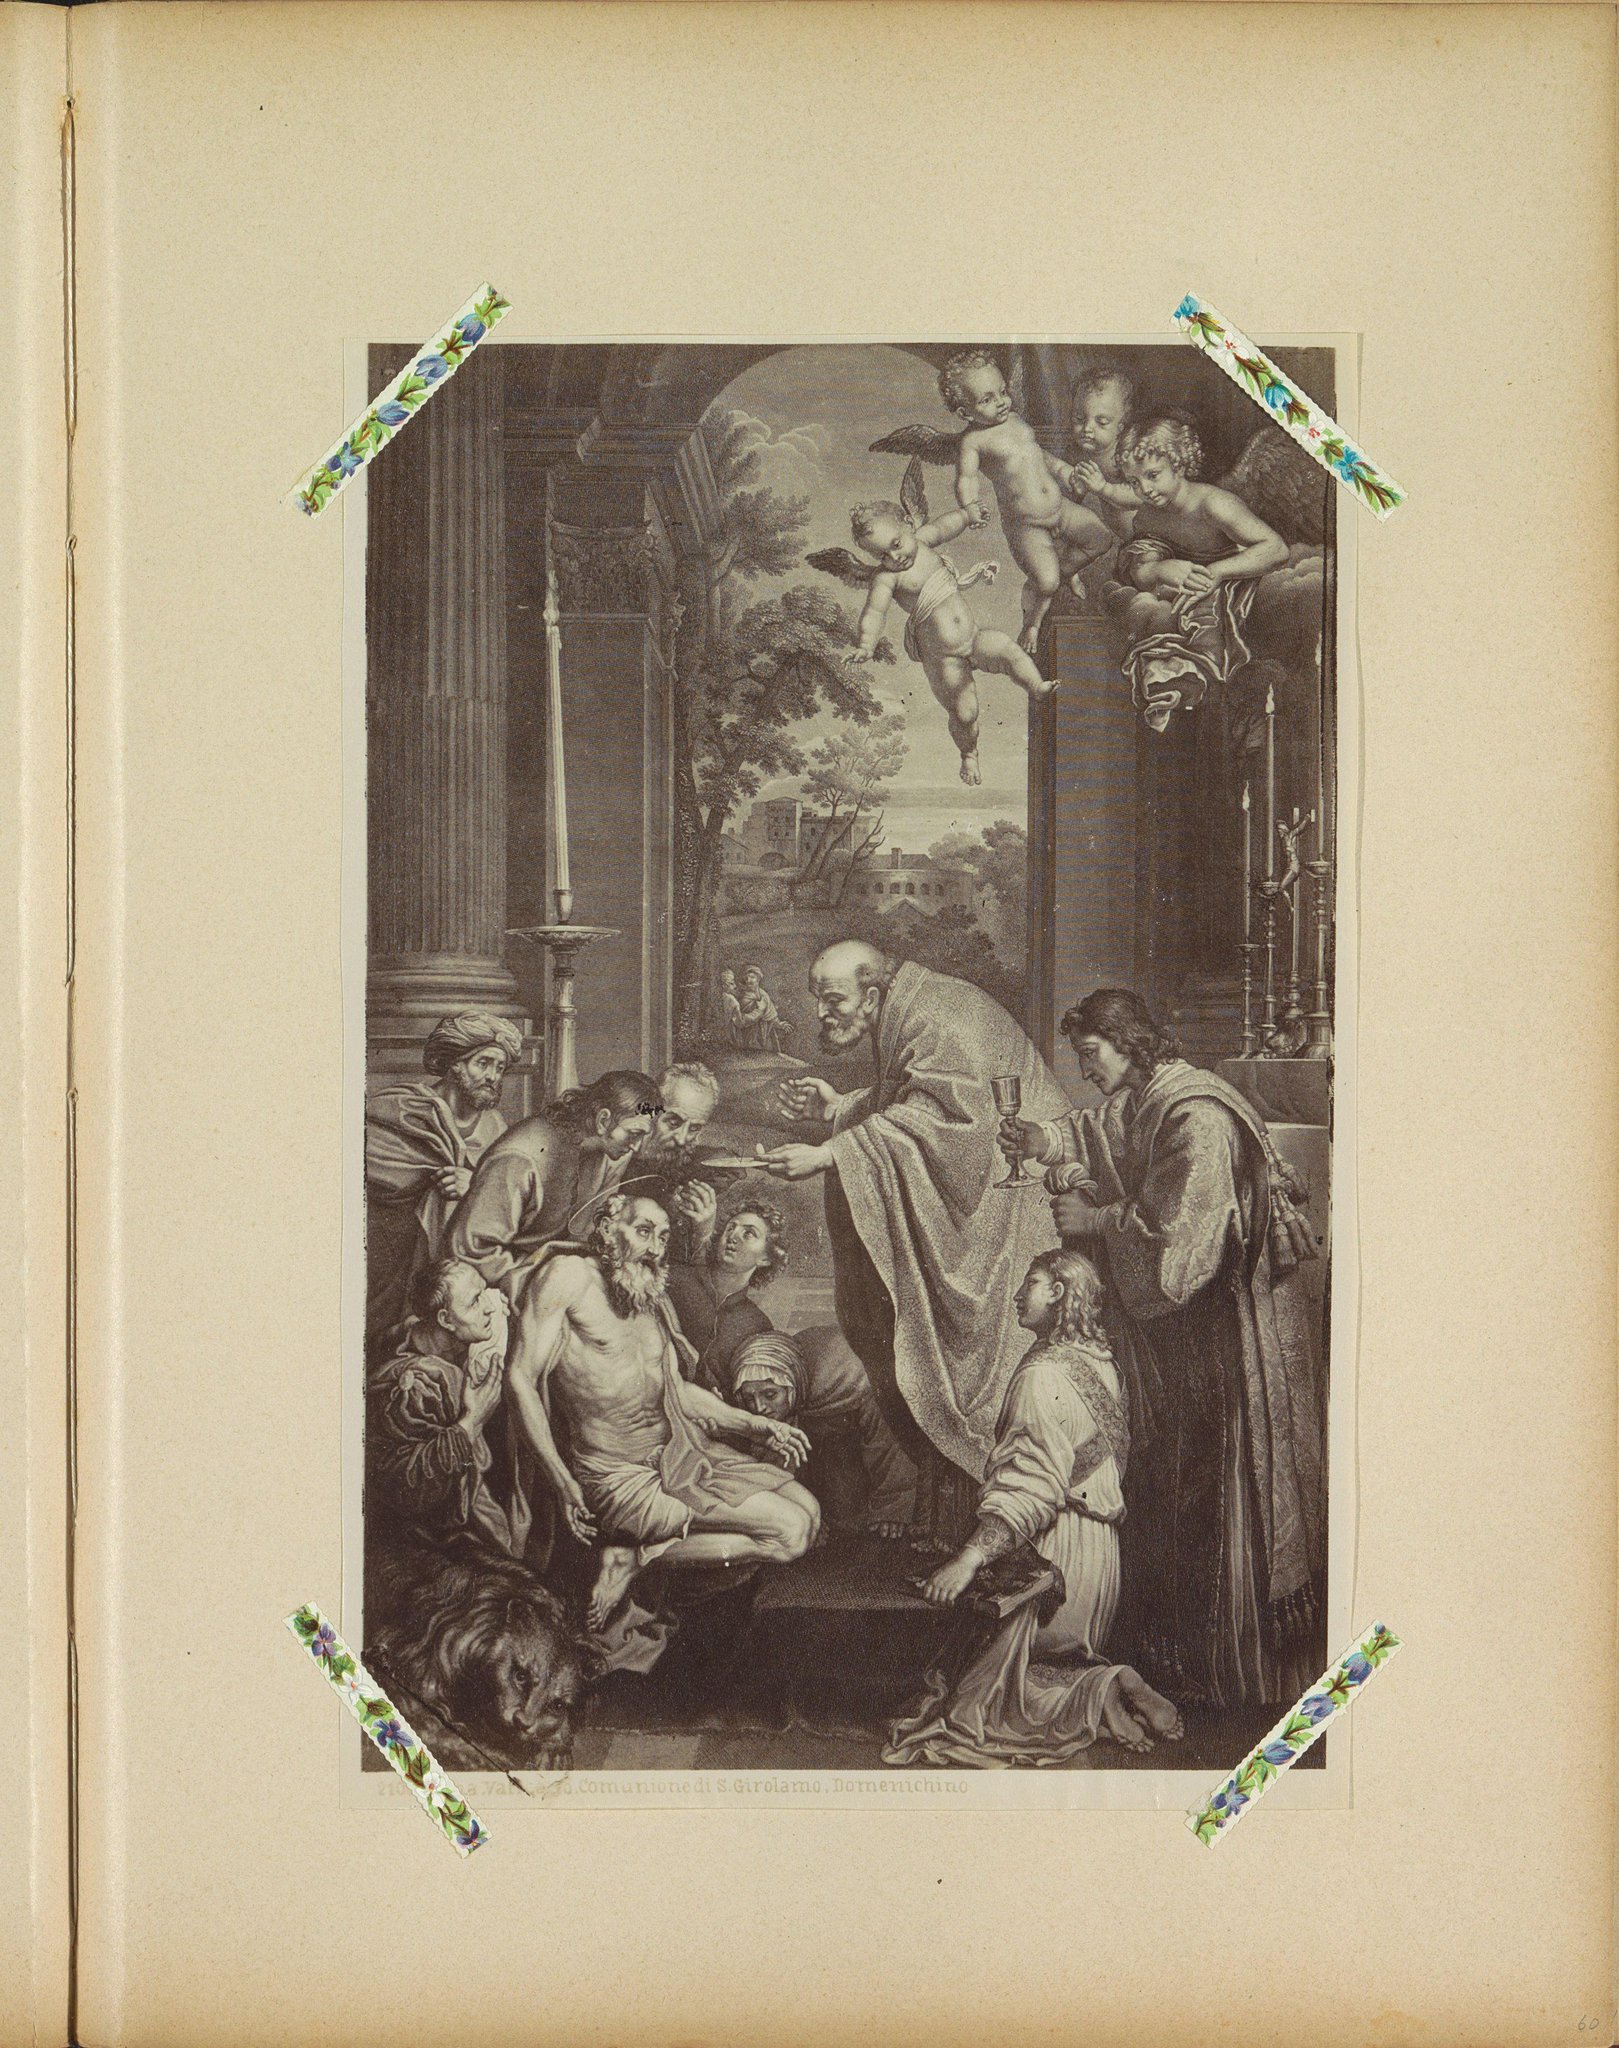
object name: reproduction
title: Fotoreproductie van een schilderij door Domenichino, voorstellend de communie van de heilige Hieronymus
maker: Anonymous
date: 1860-1900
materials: photographic support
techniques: albumen print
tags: the last communion of st. jerome: he is attended and supported by younger priests, one of whom is about to administer the sacrament; usually st. paula is present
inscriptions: number: ‘2100’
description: Onderdeel van Fotoalbum met opnames van bezienswaardigheden in Italiaanse steden en van kunstwerken.